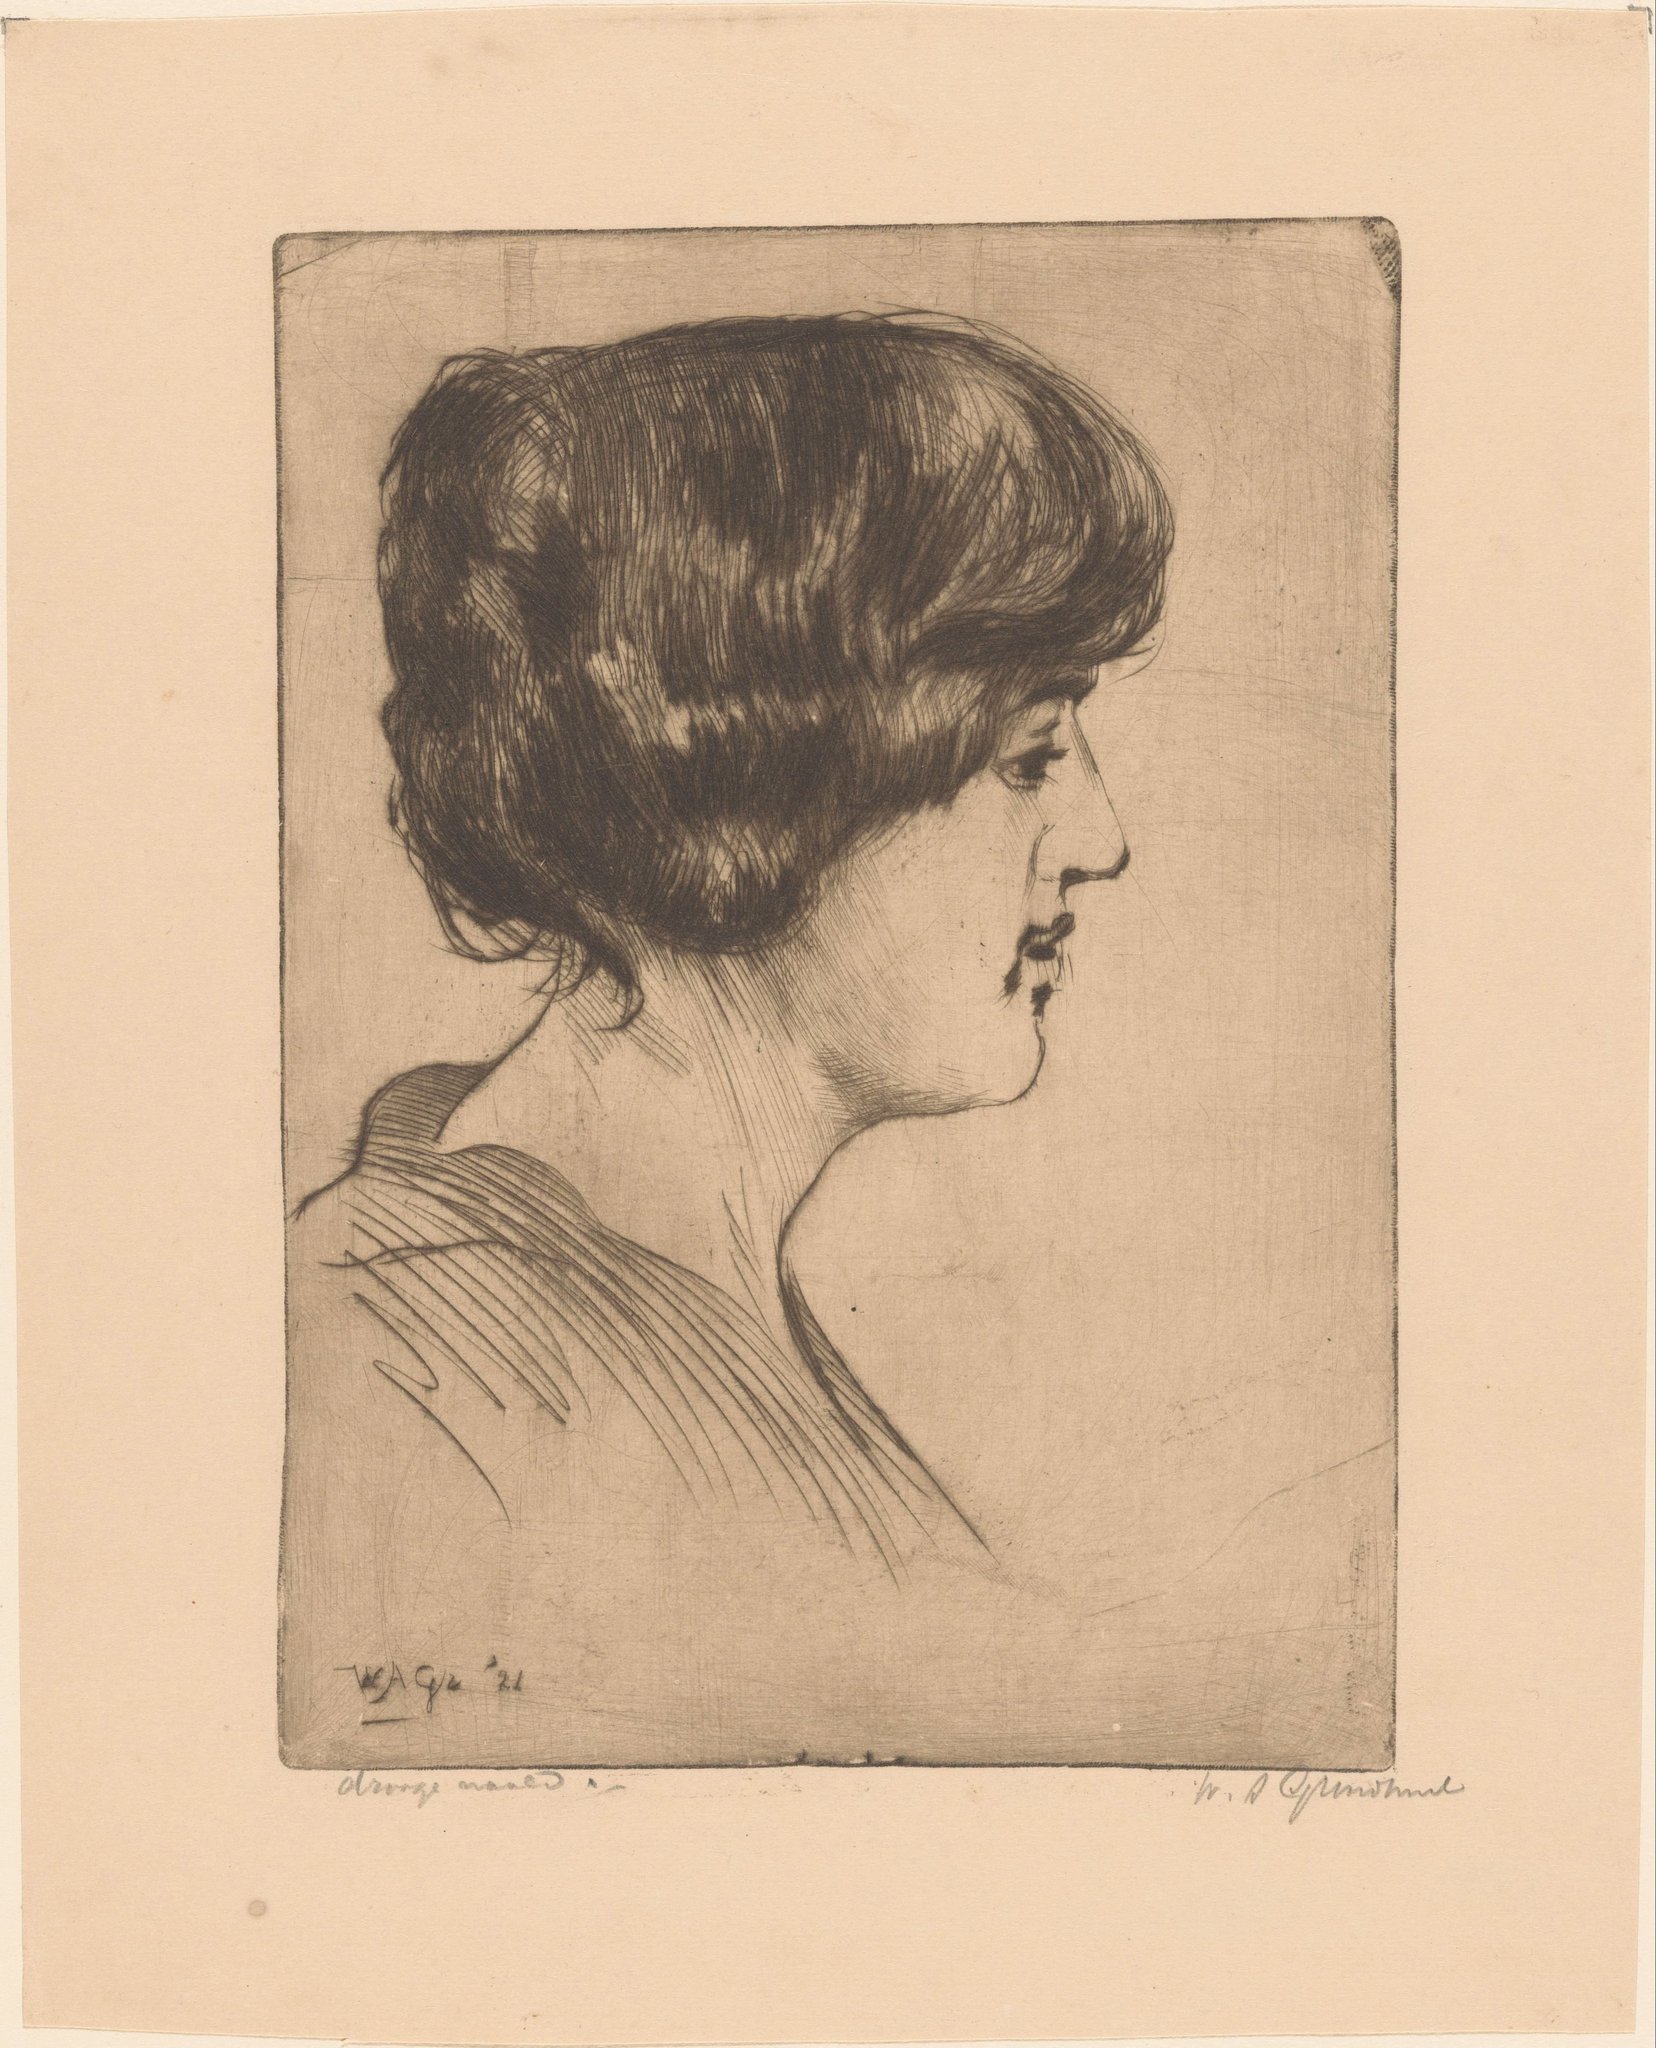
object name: print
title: Portret van een onbekende vrouw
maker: willem adrianus grondhout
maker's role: draughtsman, painter, print maker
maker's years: 1878-1934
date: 1921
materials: paper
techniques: drypoint, intaglio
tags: anonymous historical person portrayed - bb - woman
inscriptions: collector's mark: Lugt 2228